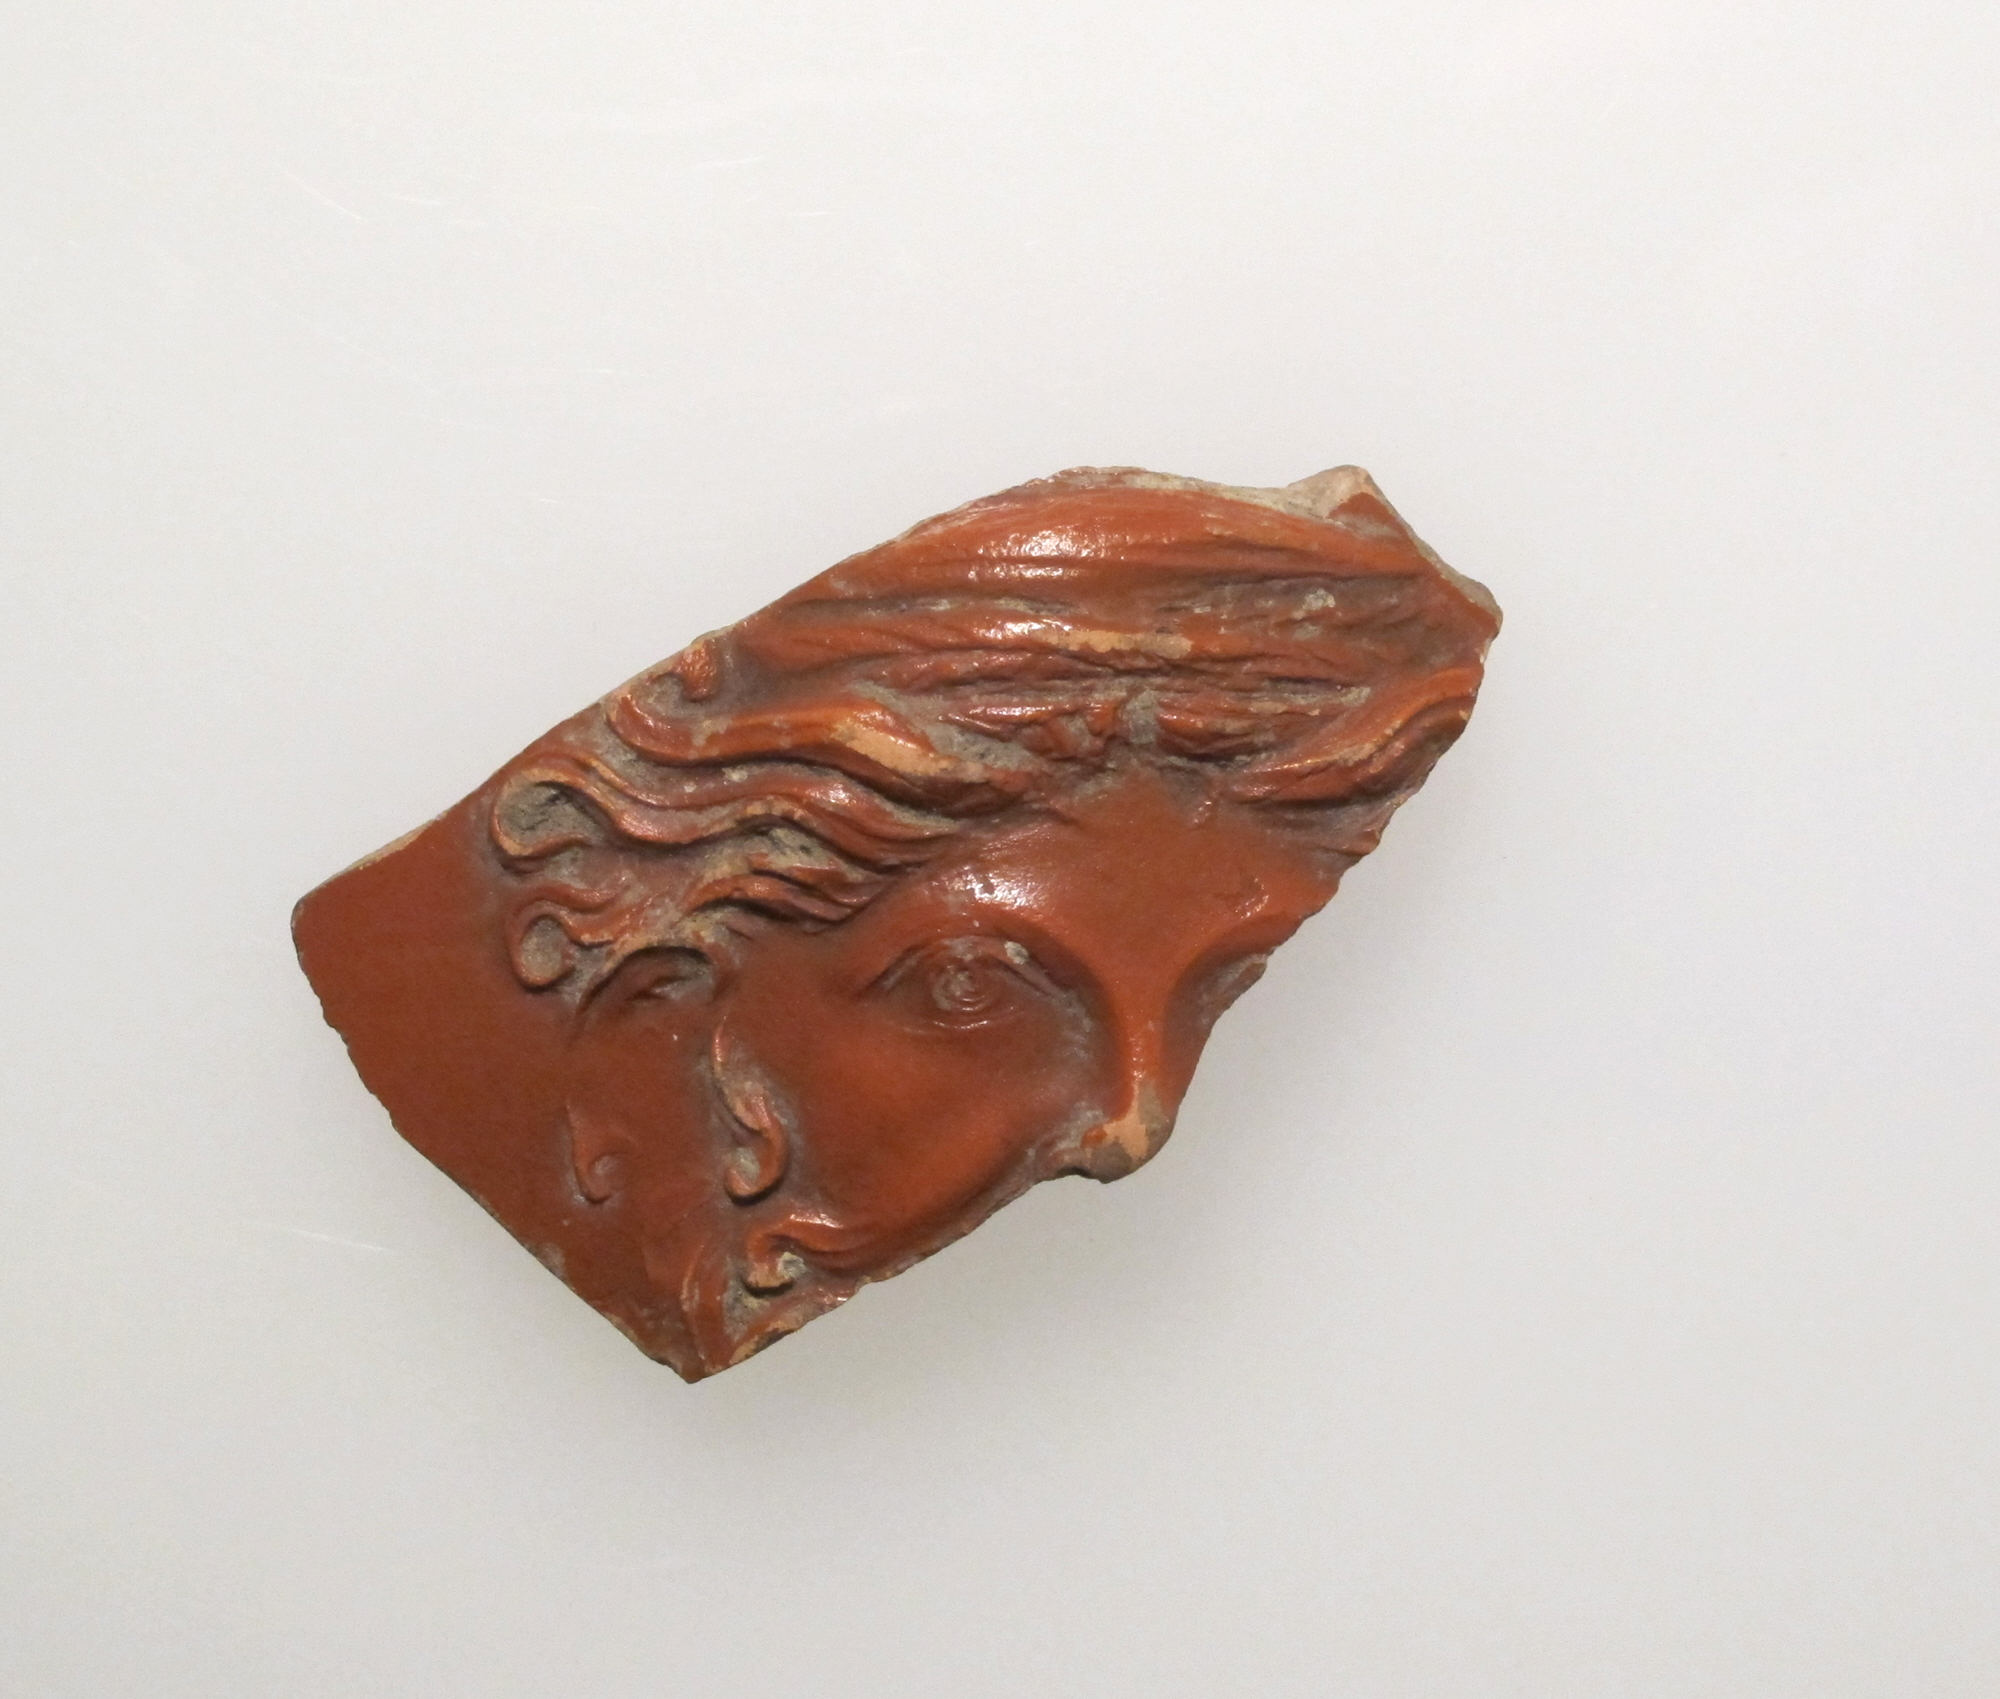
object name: vase fragment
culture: roman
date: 100 BCE-100 CE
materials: terracotta